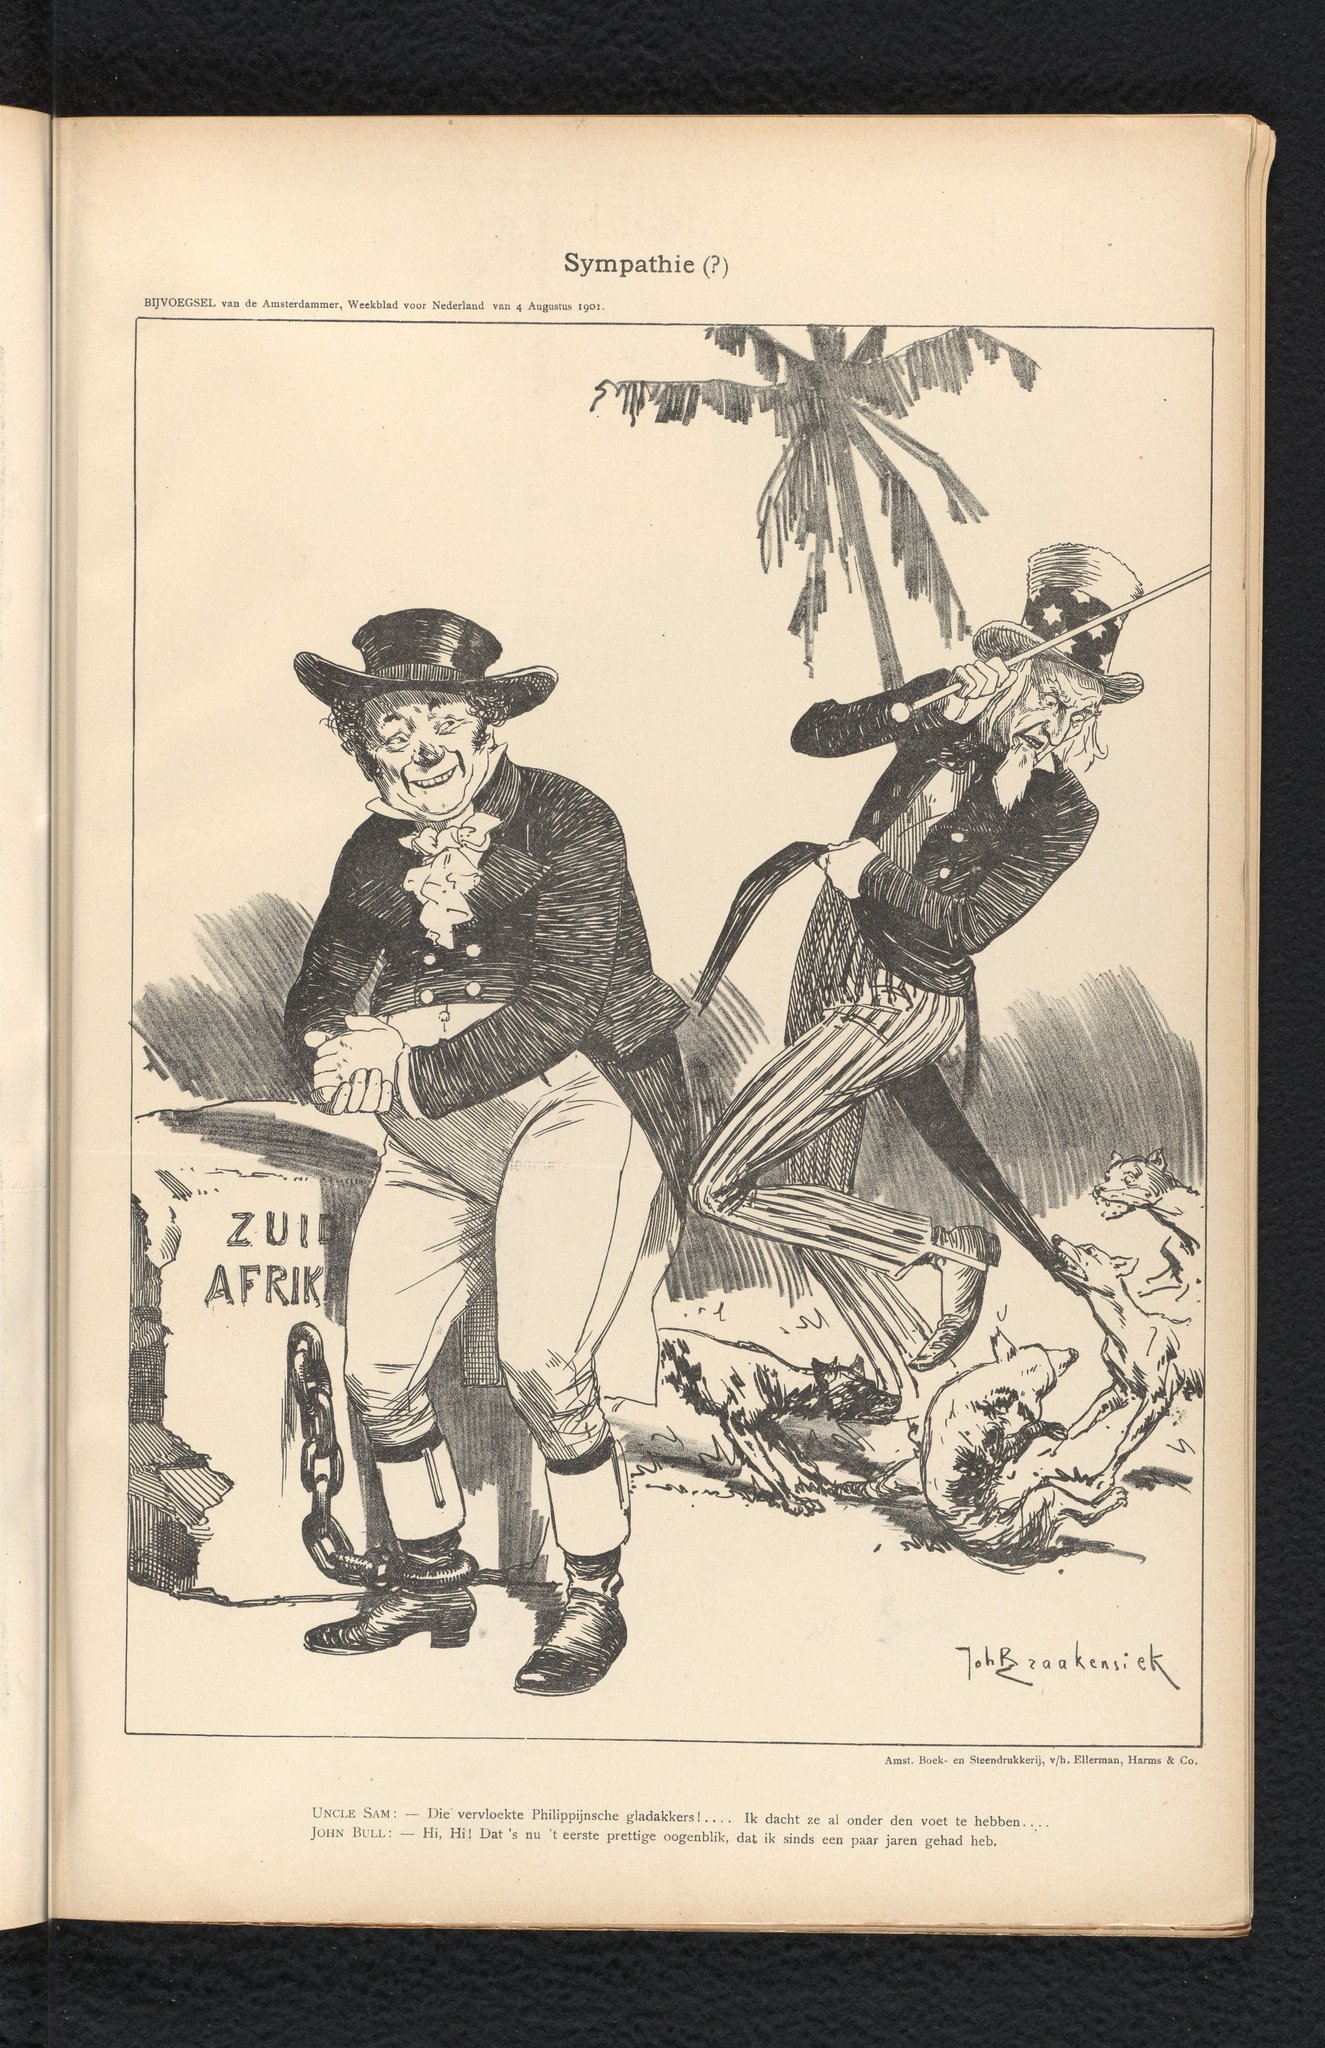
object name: cartoon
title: Sympathie (?)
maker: johan braakensiek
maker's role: draughtsman, print maker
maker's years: 1858-1940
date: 1901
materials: paper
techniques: lithograph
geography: amsterdam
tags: personifications of countries, nations, states, districts, etc., (person) in fetters, not imprisoned, political caricatures and satires, dog, philippines, philippine–american war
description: John Bull (Engeland) geketend aan het rotsblok Zuid-Afrika maakt zich vrolijk over Uncle Sam (Verenigde Staten) die bijtende honden (Filipijnen) van zich af moet slaan.